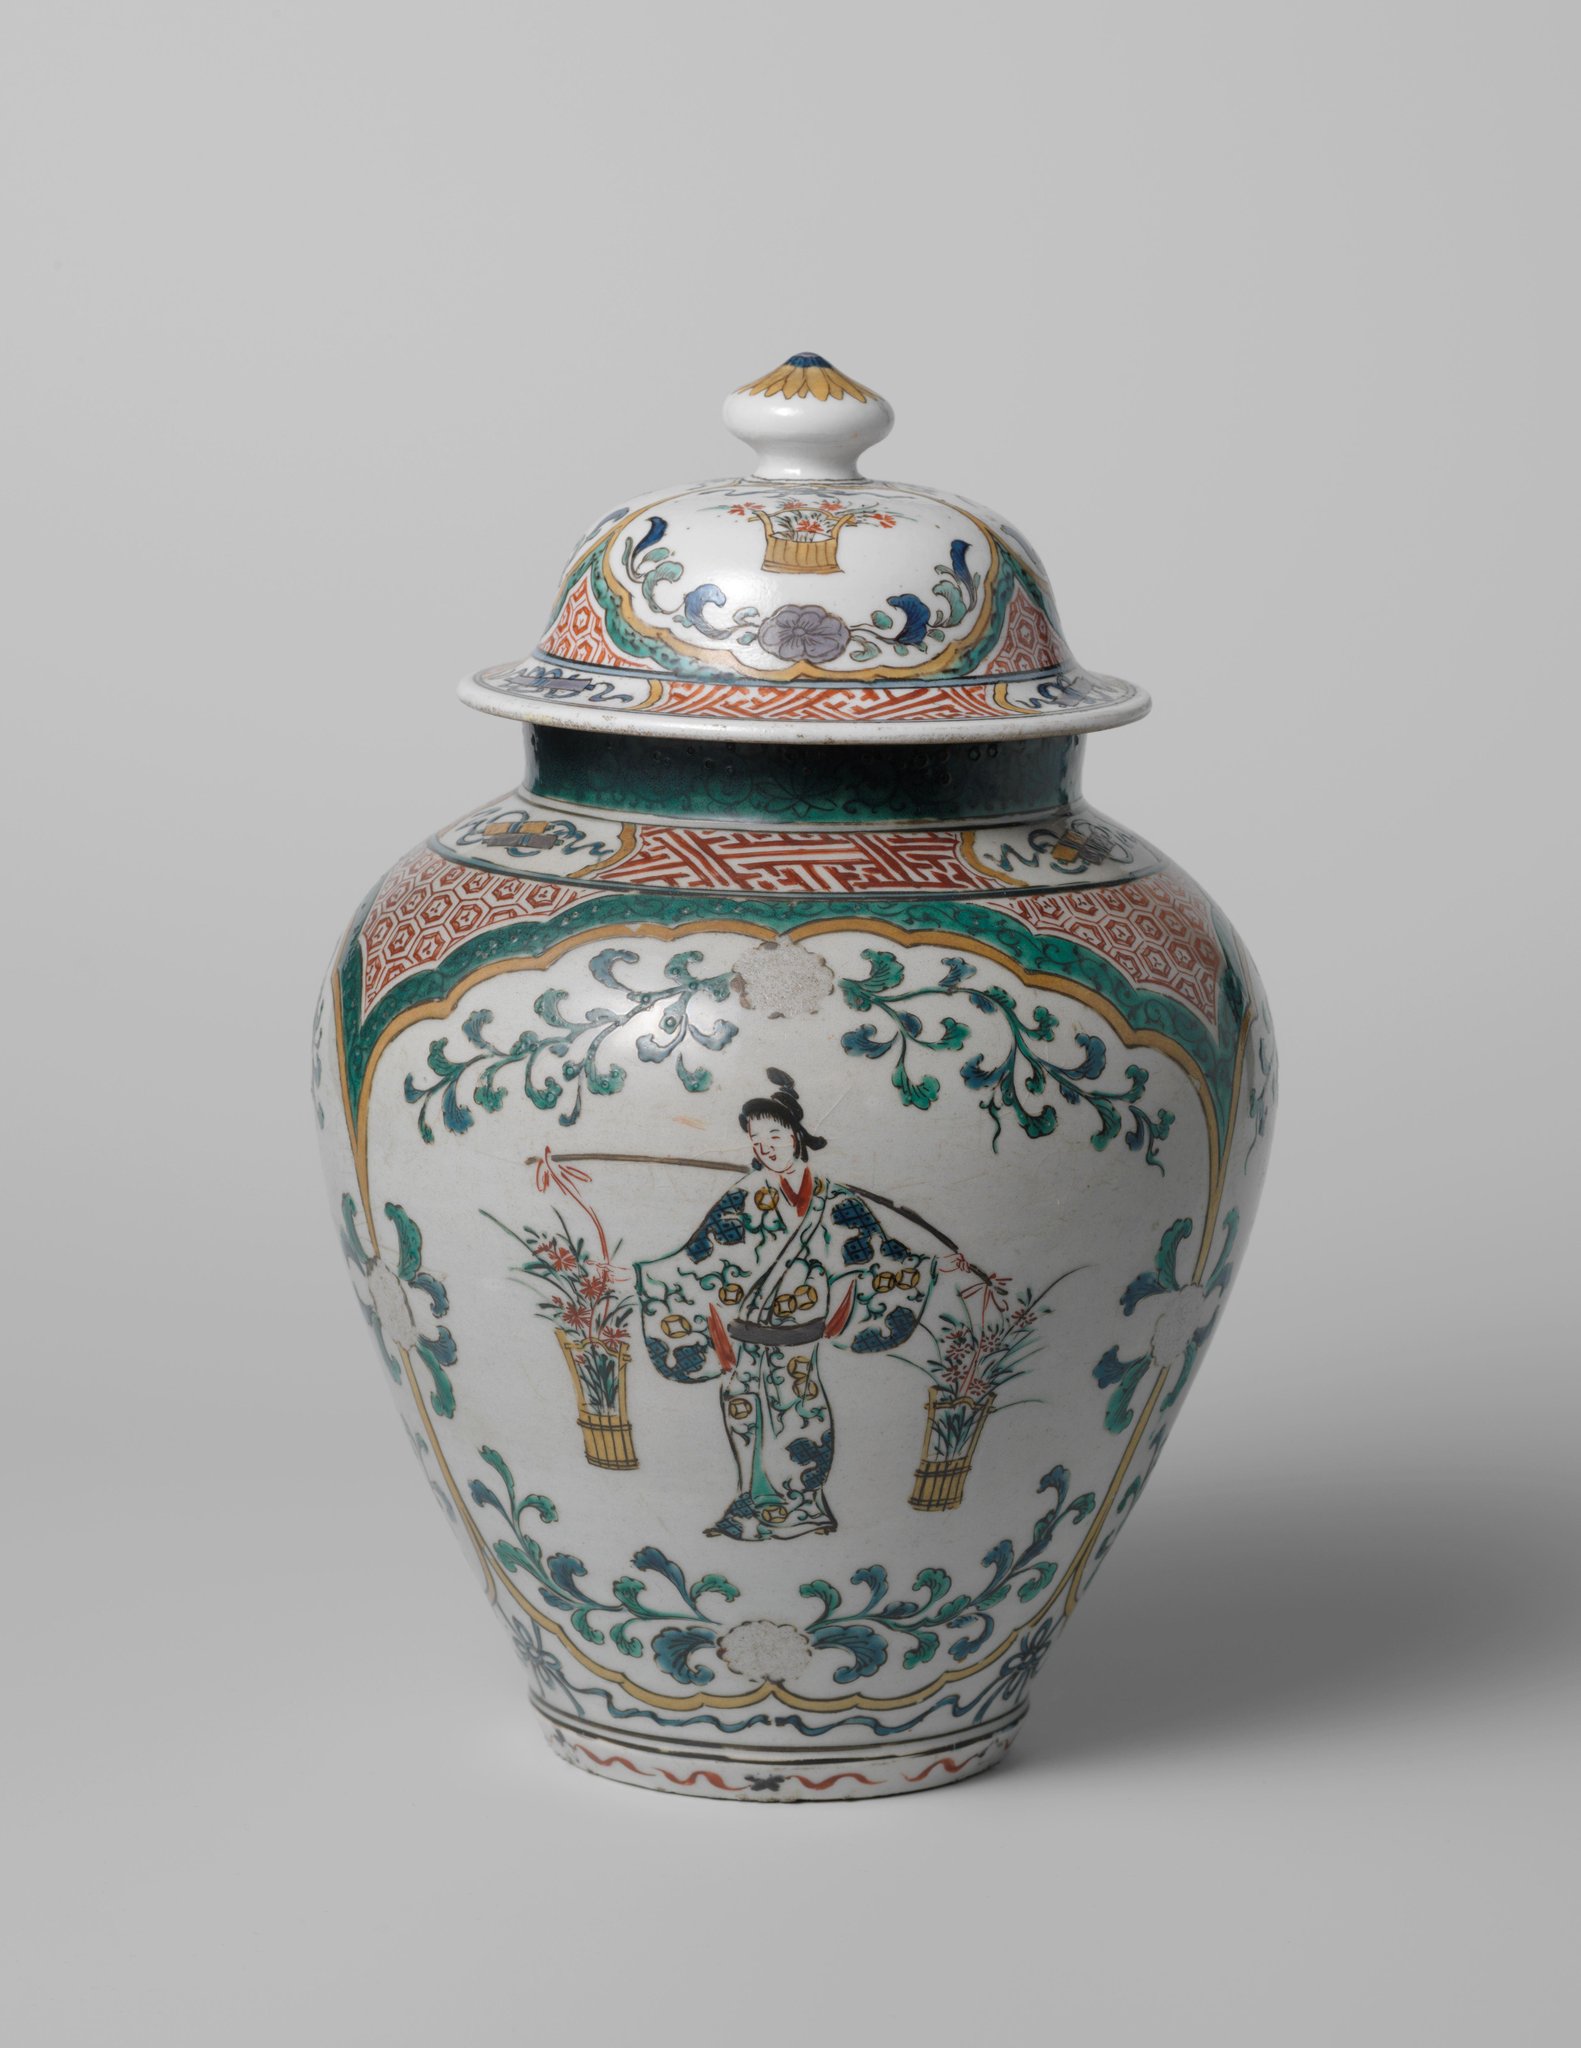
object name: covered jar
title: Ovoid jar with women with a yoke in scalloped panels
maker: Anonymous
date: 1650-1699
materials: glaze, paint, porcelain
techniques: firing, turning, vitrification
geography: kutani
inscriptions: mark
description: Deksel van eivormige dekselpot van porselein, beschilderd op het glazuur in blauw, rood, groen, geel, aubergine en zwart. Gedecoreerd met drie grote, geschulpte cartouches met bloemenmanden. Boven de cartouches een band met bladranken. Tussen de cartouches geschulpte driehoeken met servetwerk. Op de schouder een band met servetwerk onderbroken door gelobde cartouches met kostbaarheden (boeken). Op de nek een band met lotusranken. Kutani.